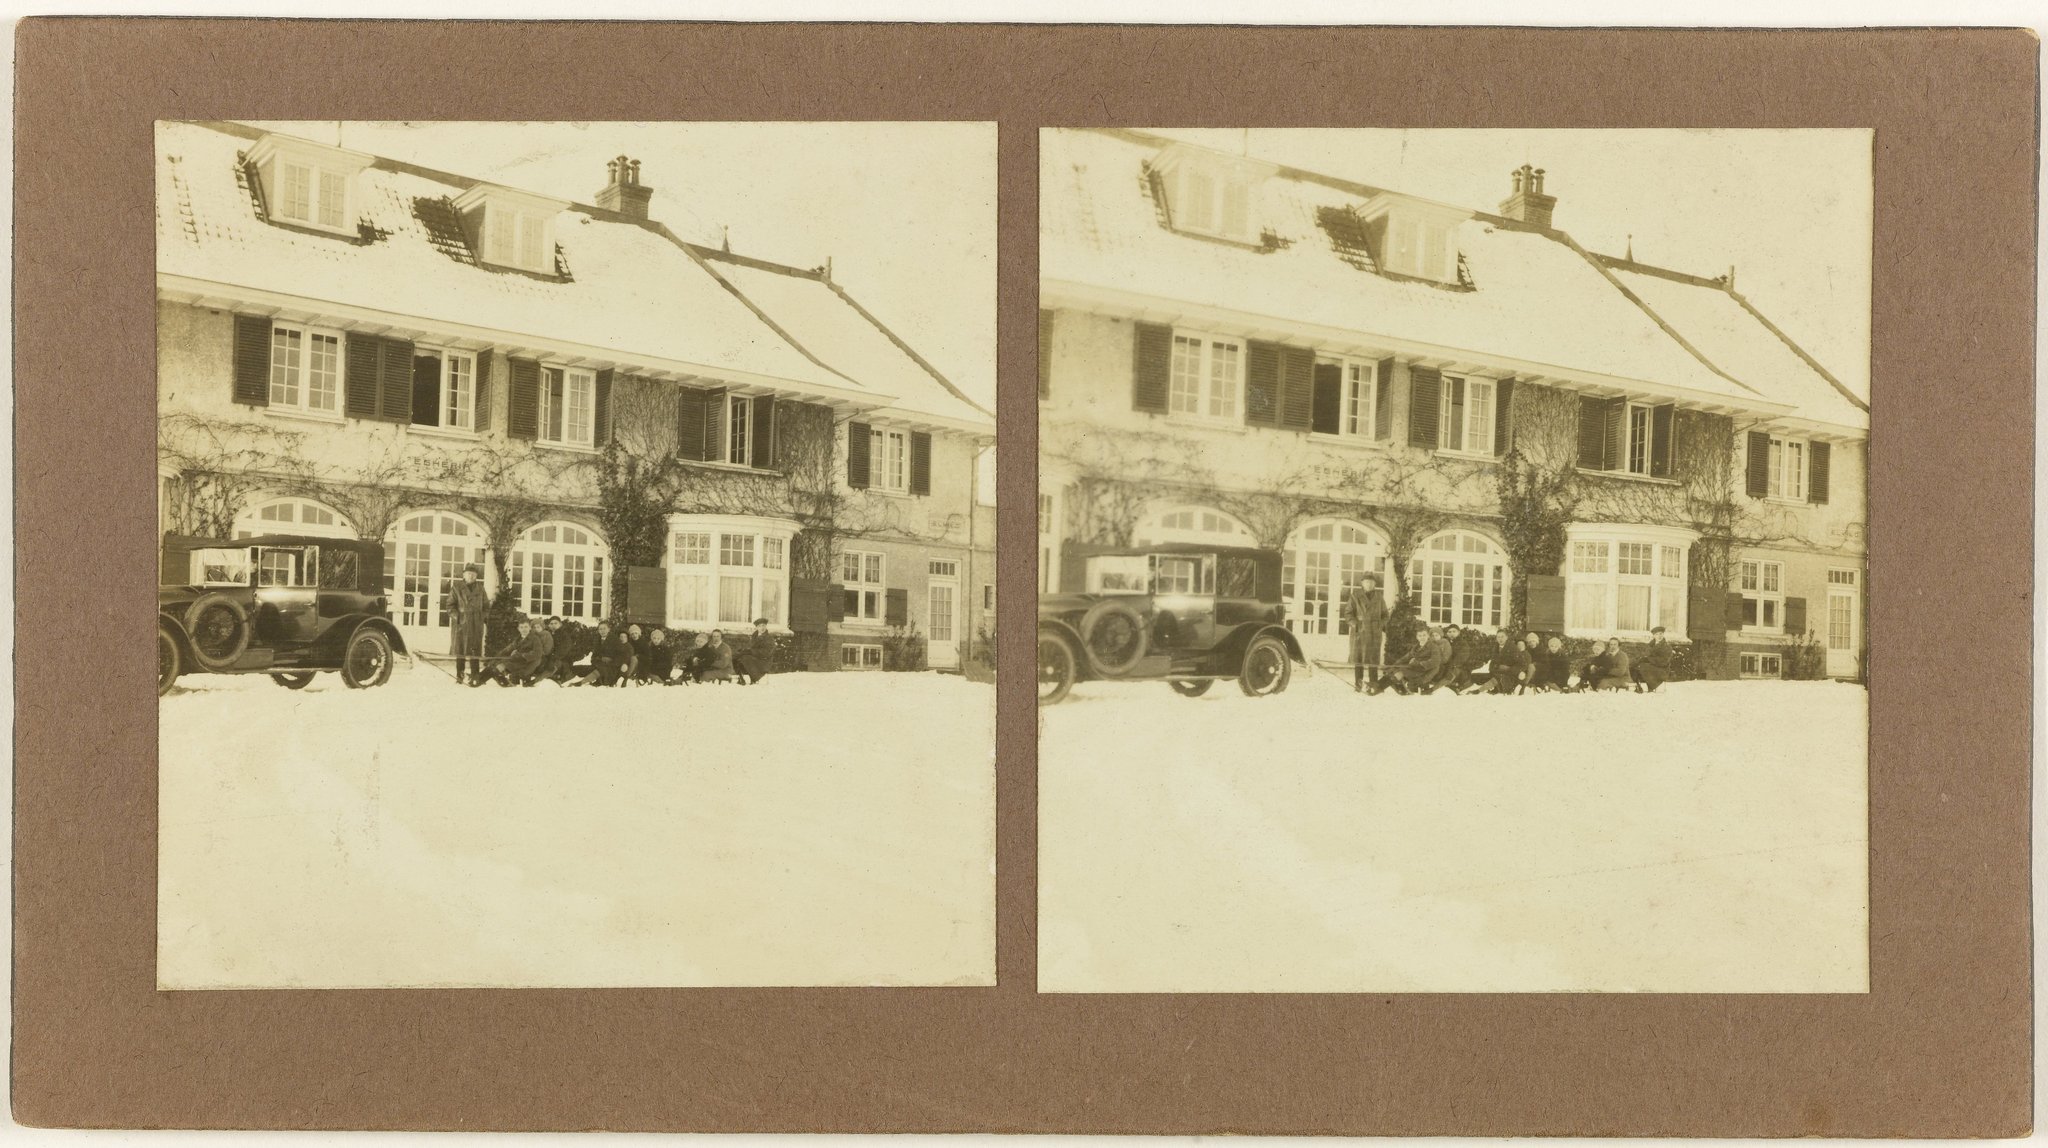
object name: stereograph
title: Kinderen op de slee achter een auto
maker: e. ten cate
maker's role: fotograaf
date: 1908-1914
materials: cardboard, photographic support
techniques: gelatin silver print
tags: sledge, sleigh (winter sports), automobile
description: Voor een huis staat een auto met een rijtje sleeën erachter gebonden waarop kinderen zitten.